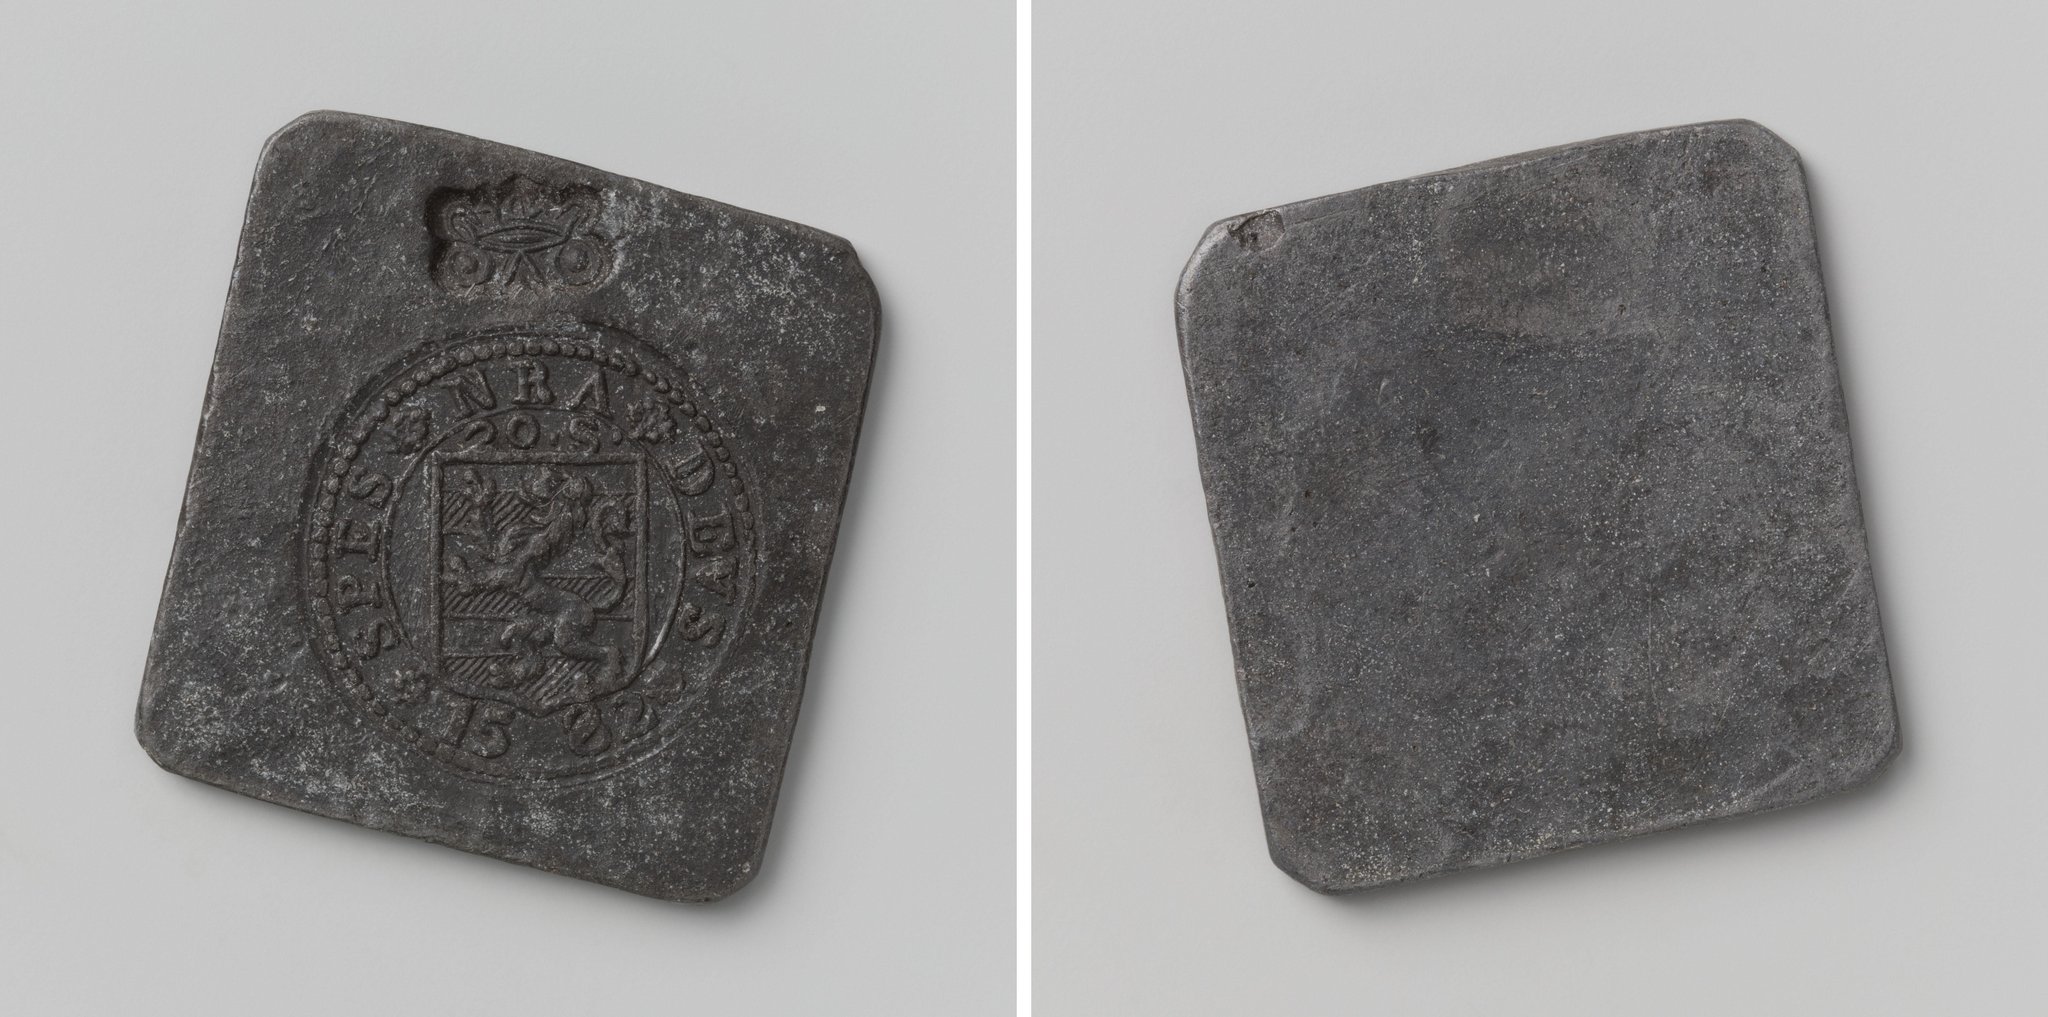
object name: twintig stuiver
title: Twintig stuiver, noodmunt uit Oudenaarde, kopie van een noodmunt geslagen tijdens het beleg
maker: Anonymous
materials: tin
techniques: striking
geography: belgium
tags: oudenaarde, beleg en inname van oudenaarde (1582), tachtigjarige oorlog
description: eenzijdige, rechthoekige noodmunt met afgeronde hoeken. Voorzijde: twee stempels: klop: stadsmerk; daaronder ronde stempel: wapenschild onder waardeaanduiding binnen omschrift. Keerzijde: blanco